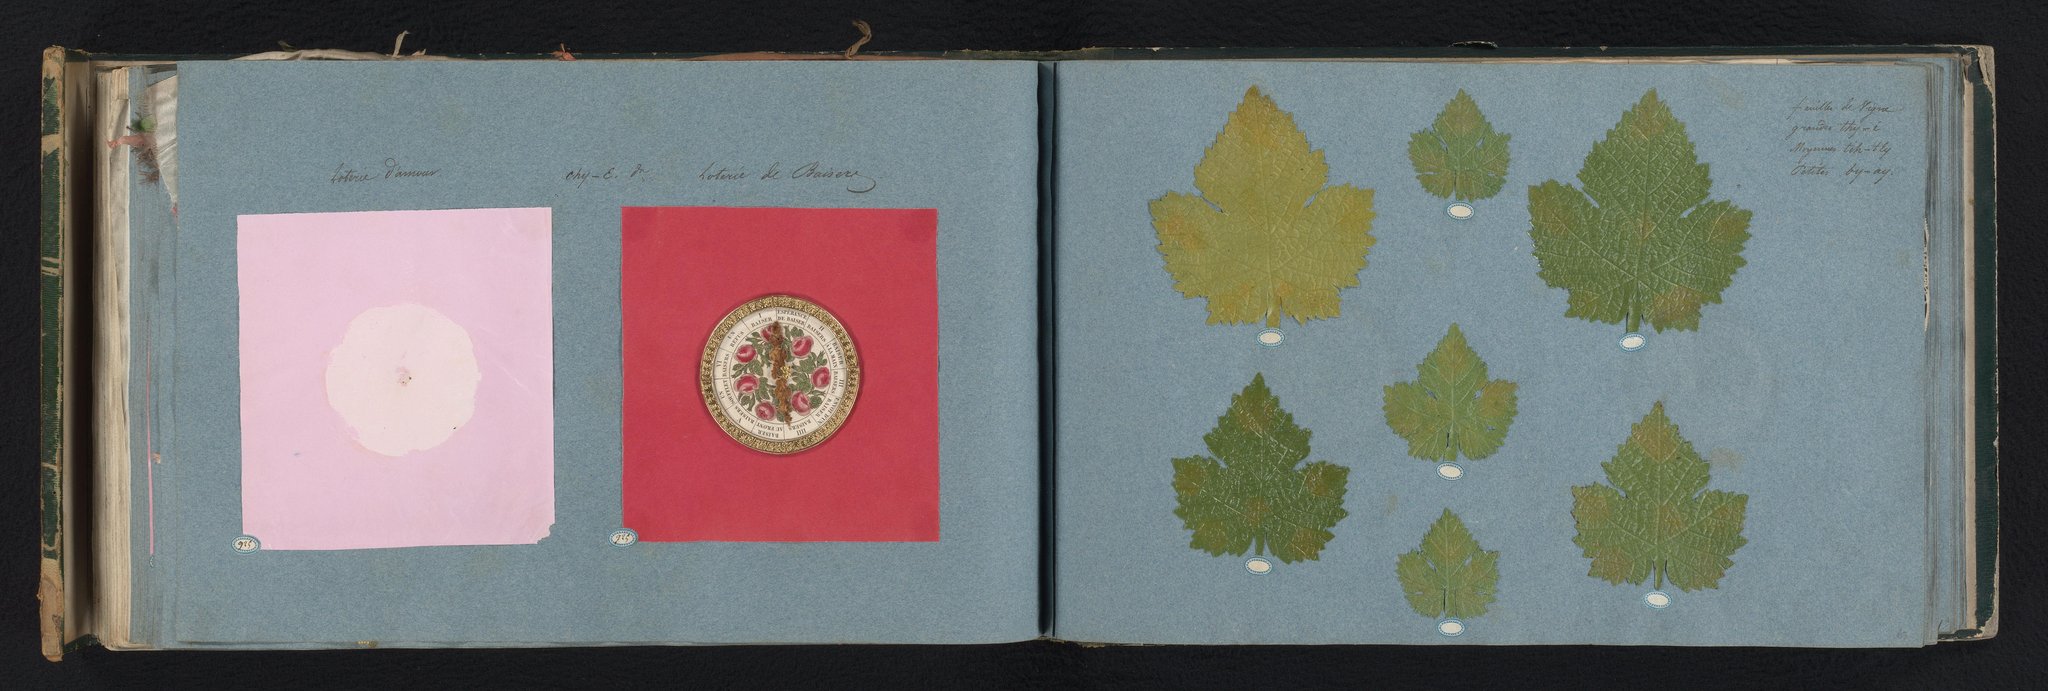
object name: print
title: Twee bladzijden met stalen van groene druivenbladeren en een draairad voor een kusspel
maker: Anonymous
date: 1830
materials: gold leaf, ink, paper, watercolor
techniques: manufacturing, etching, hand coloring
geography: france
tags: ornaments ~ art, vine-tendril, leaf, flowers: rose, party games with erotic implications, e.g.: kissing contest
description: Twee bladzijden met links één draairad (één ontbreekt) voor een kus- of zoenspel. Geëtste en ingekleurde ronde voorstelling van rozen waarop een draaibare wijzer is bevestigd, in een omlijsting van goudkleurig metaalpapier. Rechts 7 stalen van groene druivenbladeren in drie verschillende formaten van gegaufreerd papier. Alleen de stalen links voorzien van etiketten met nummers (925), beide bladen met handgeschreven codes. Onderdeel van het stalenboek geschonken door de dames Van Rijn, vermoedelijk van een Franse papierfabrikant van luxe papieren, of diens vertegenwoordiger in Nederland, ca. 1830.